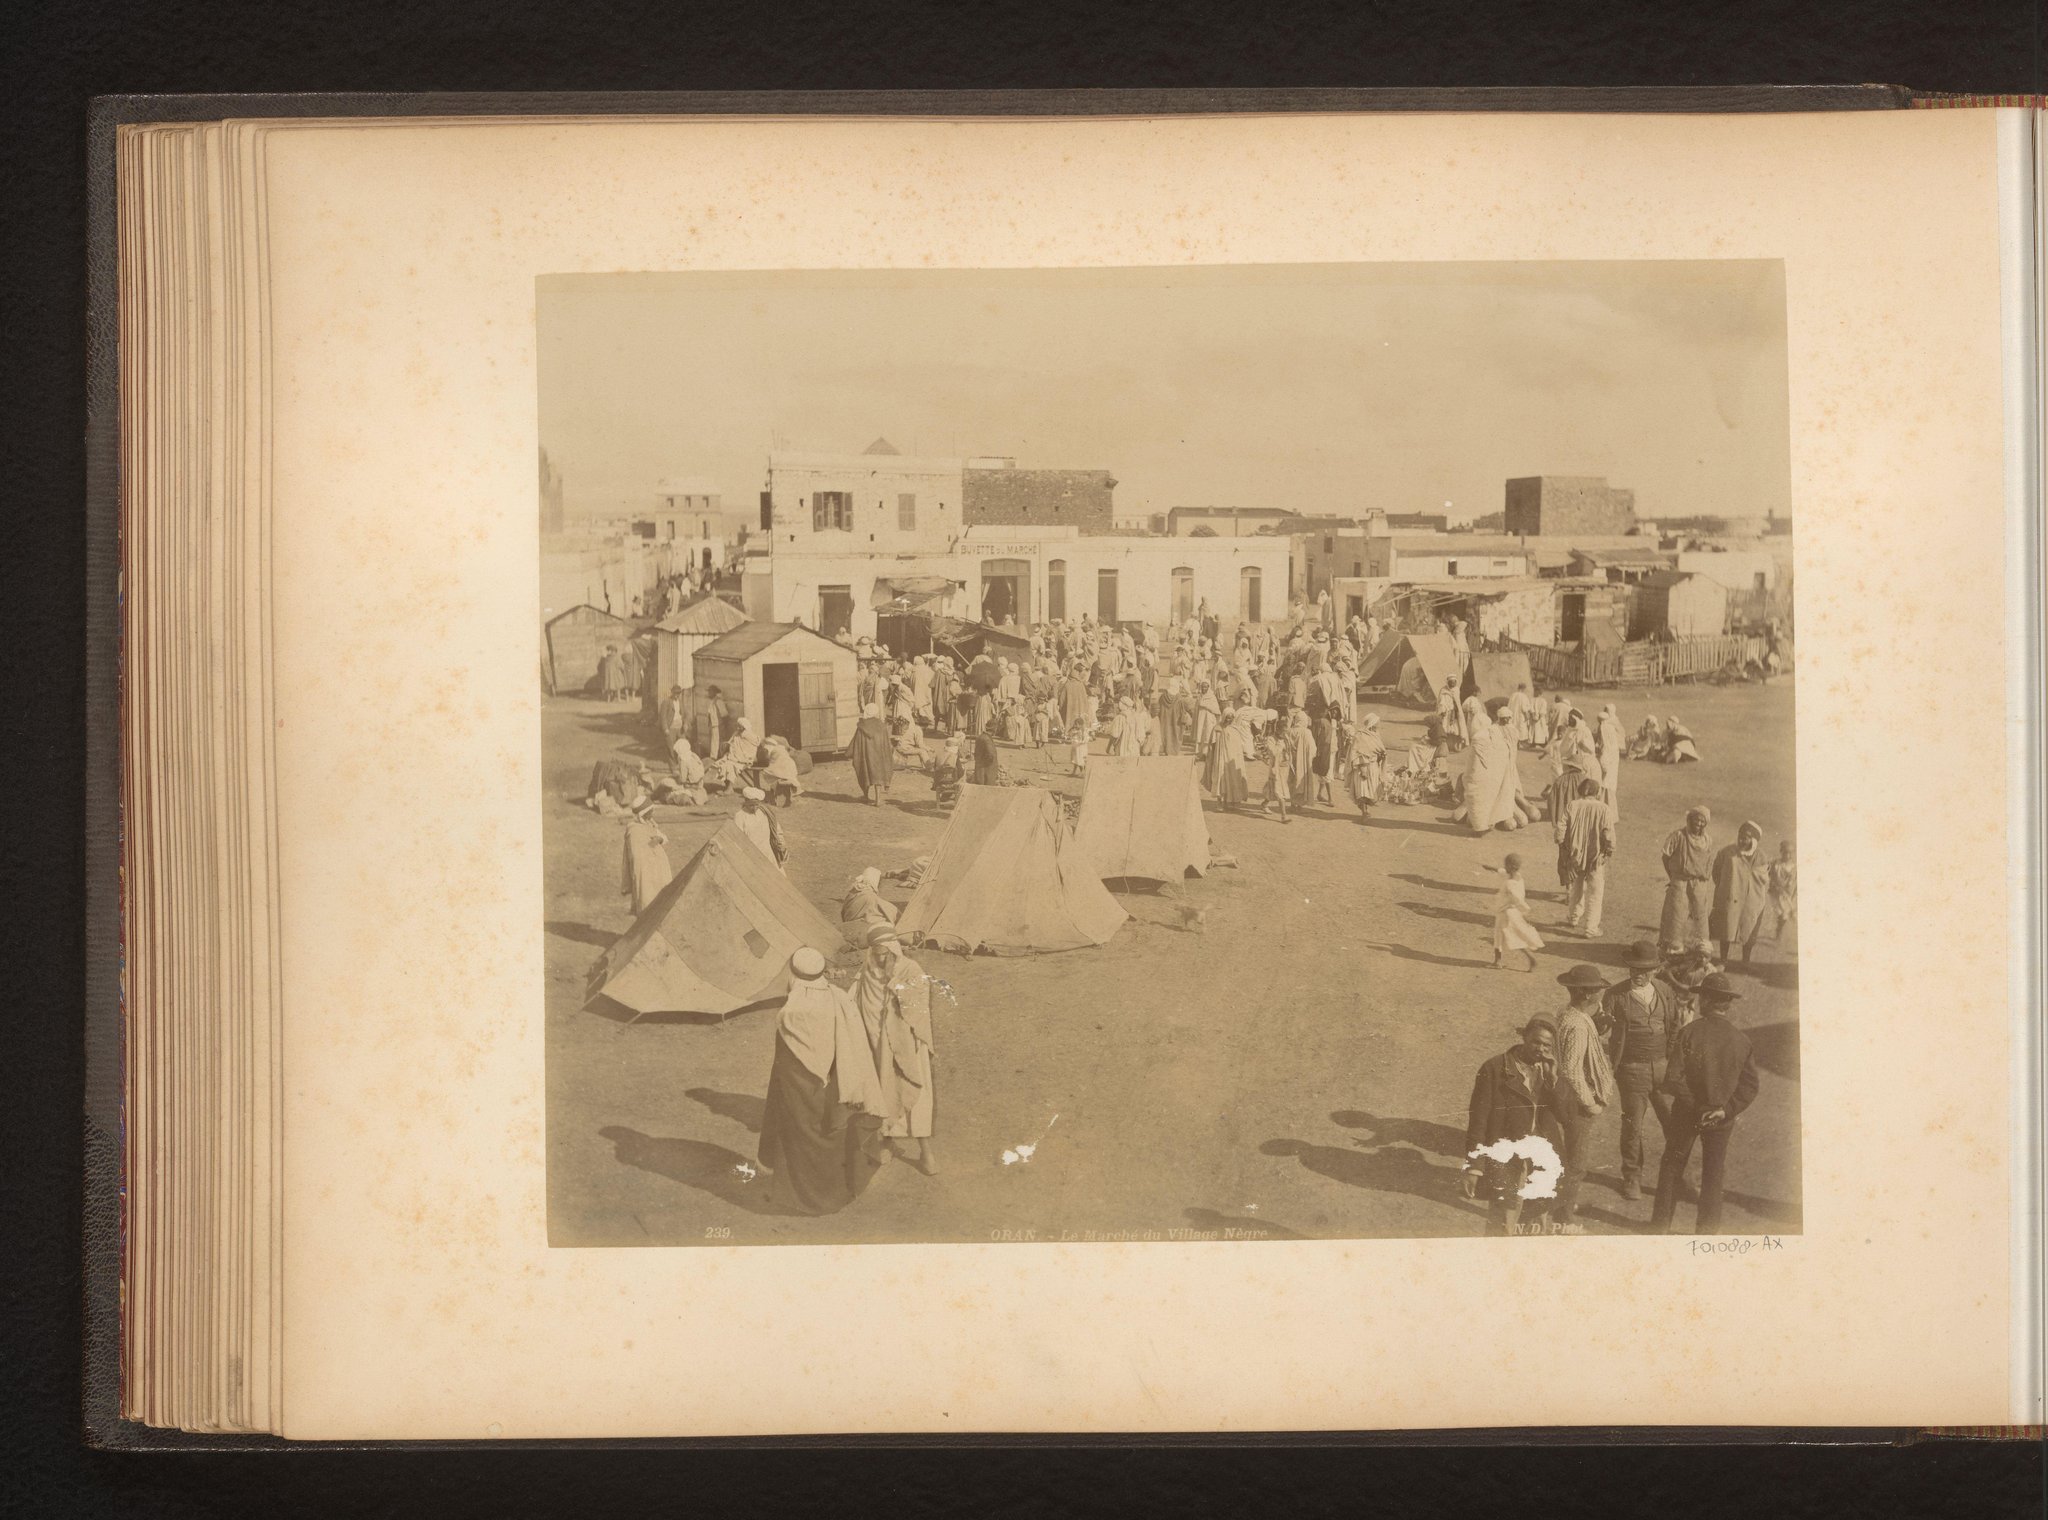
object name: album leaf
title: Markt te Oran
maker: étienne neurdein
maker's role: publisher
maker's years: 1832-1918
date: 1880-1900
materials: photographic support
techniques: albumen print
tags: historical persons, market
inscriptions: number: ‘239’